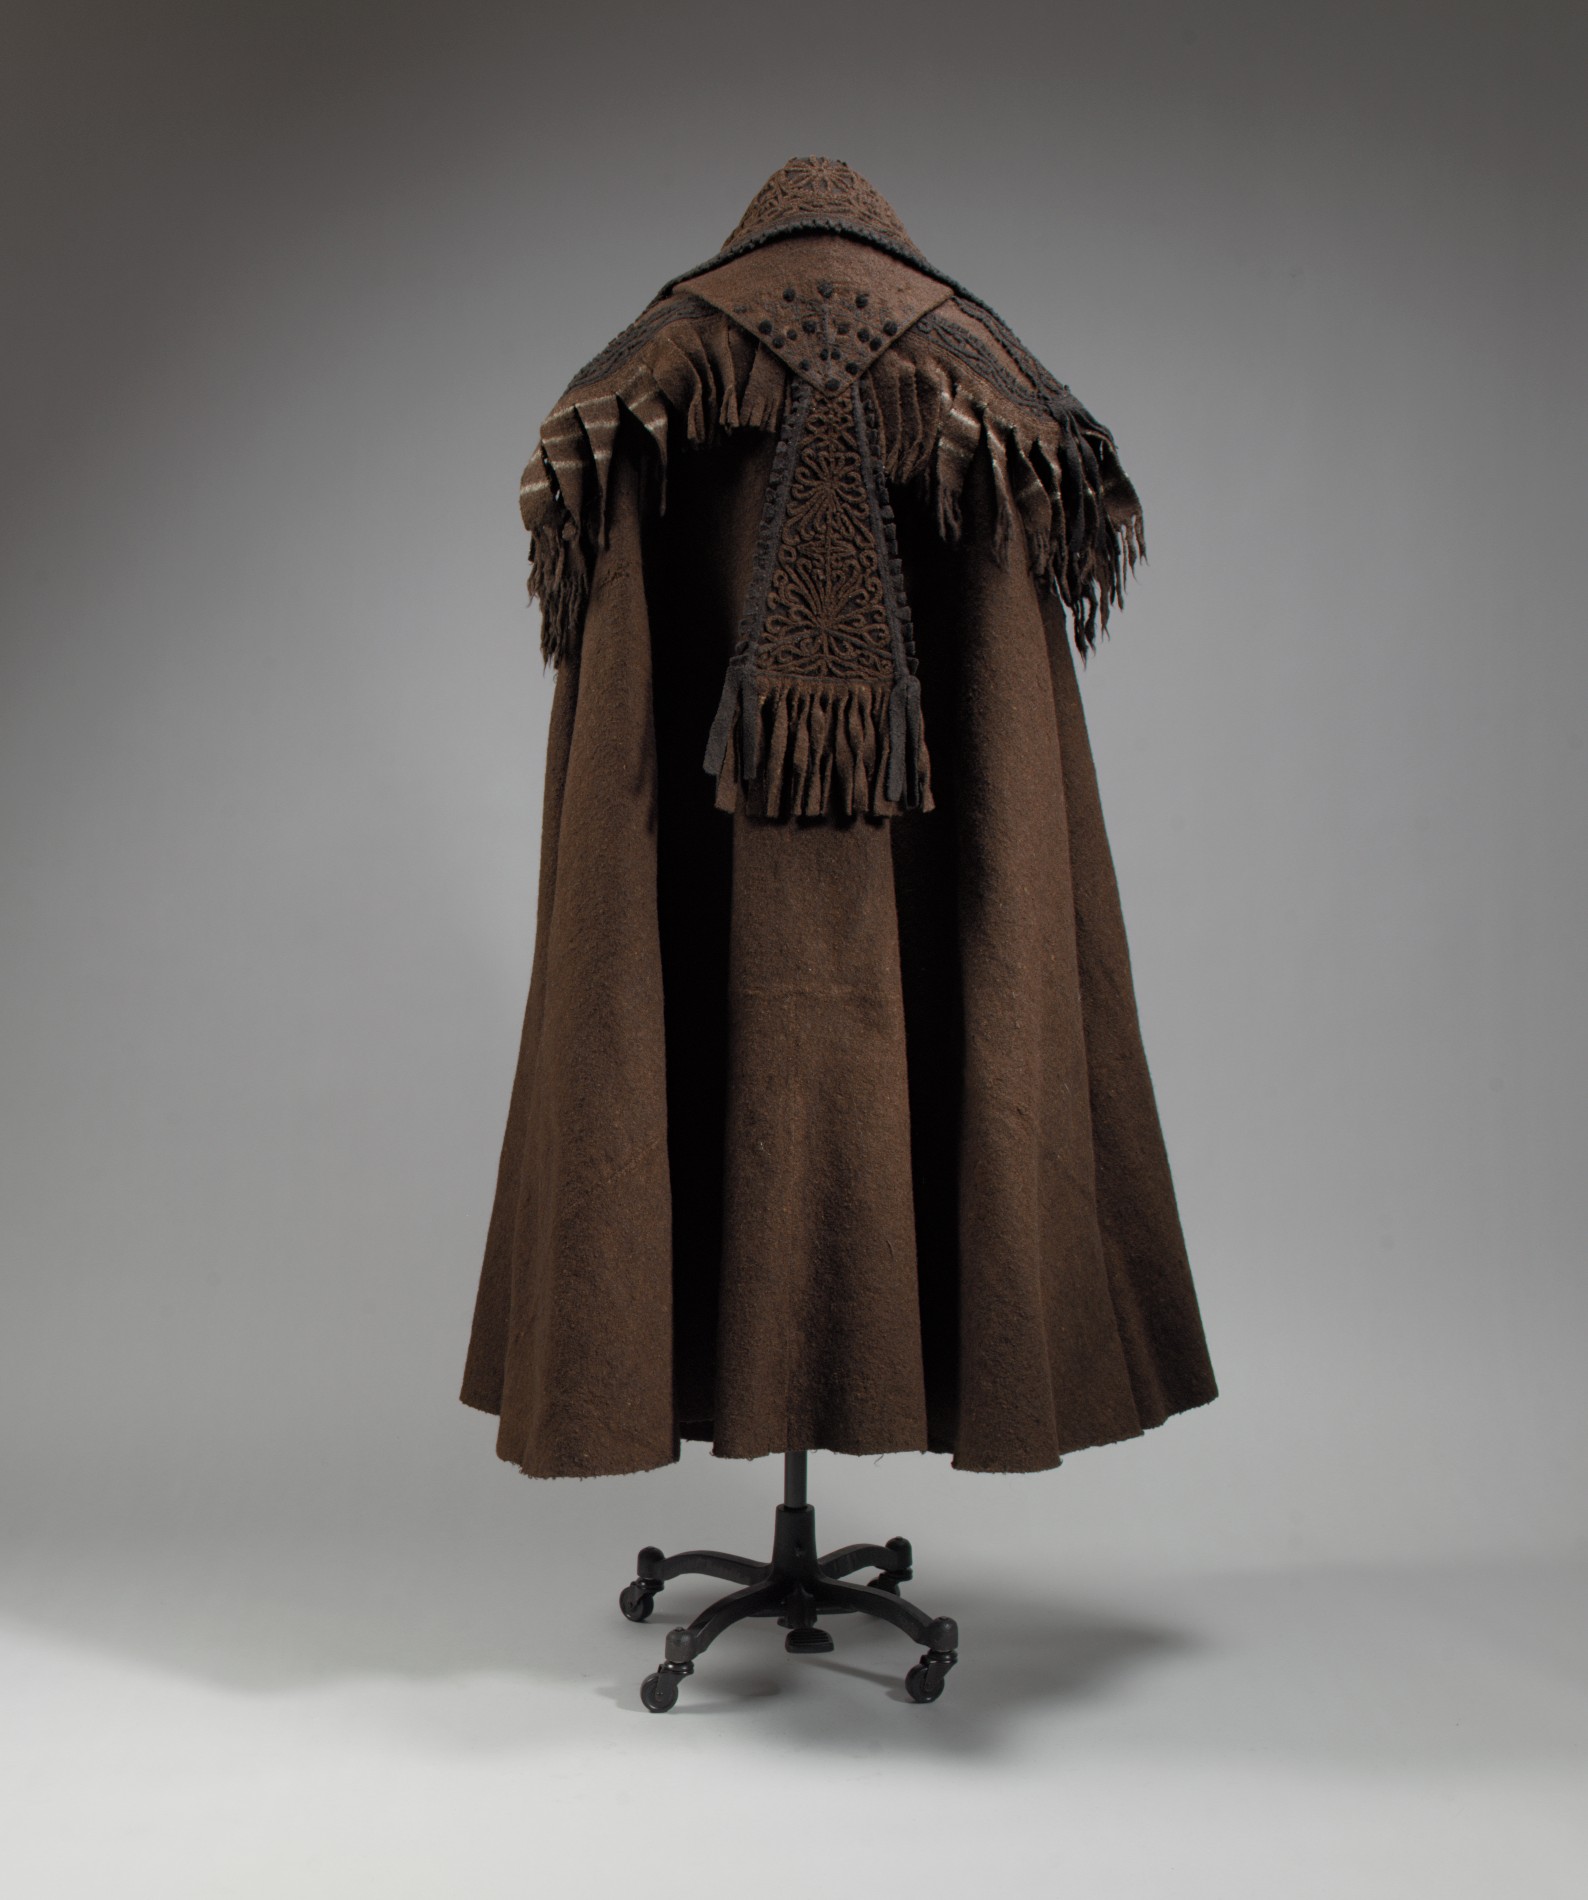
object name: ensemble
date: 1801-1900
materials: linen, metal, wool